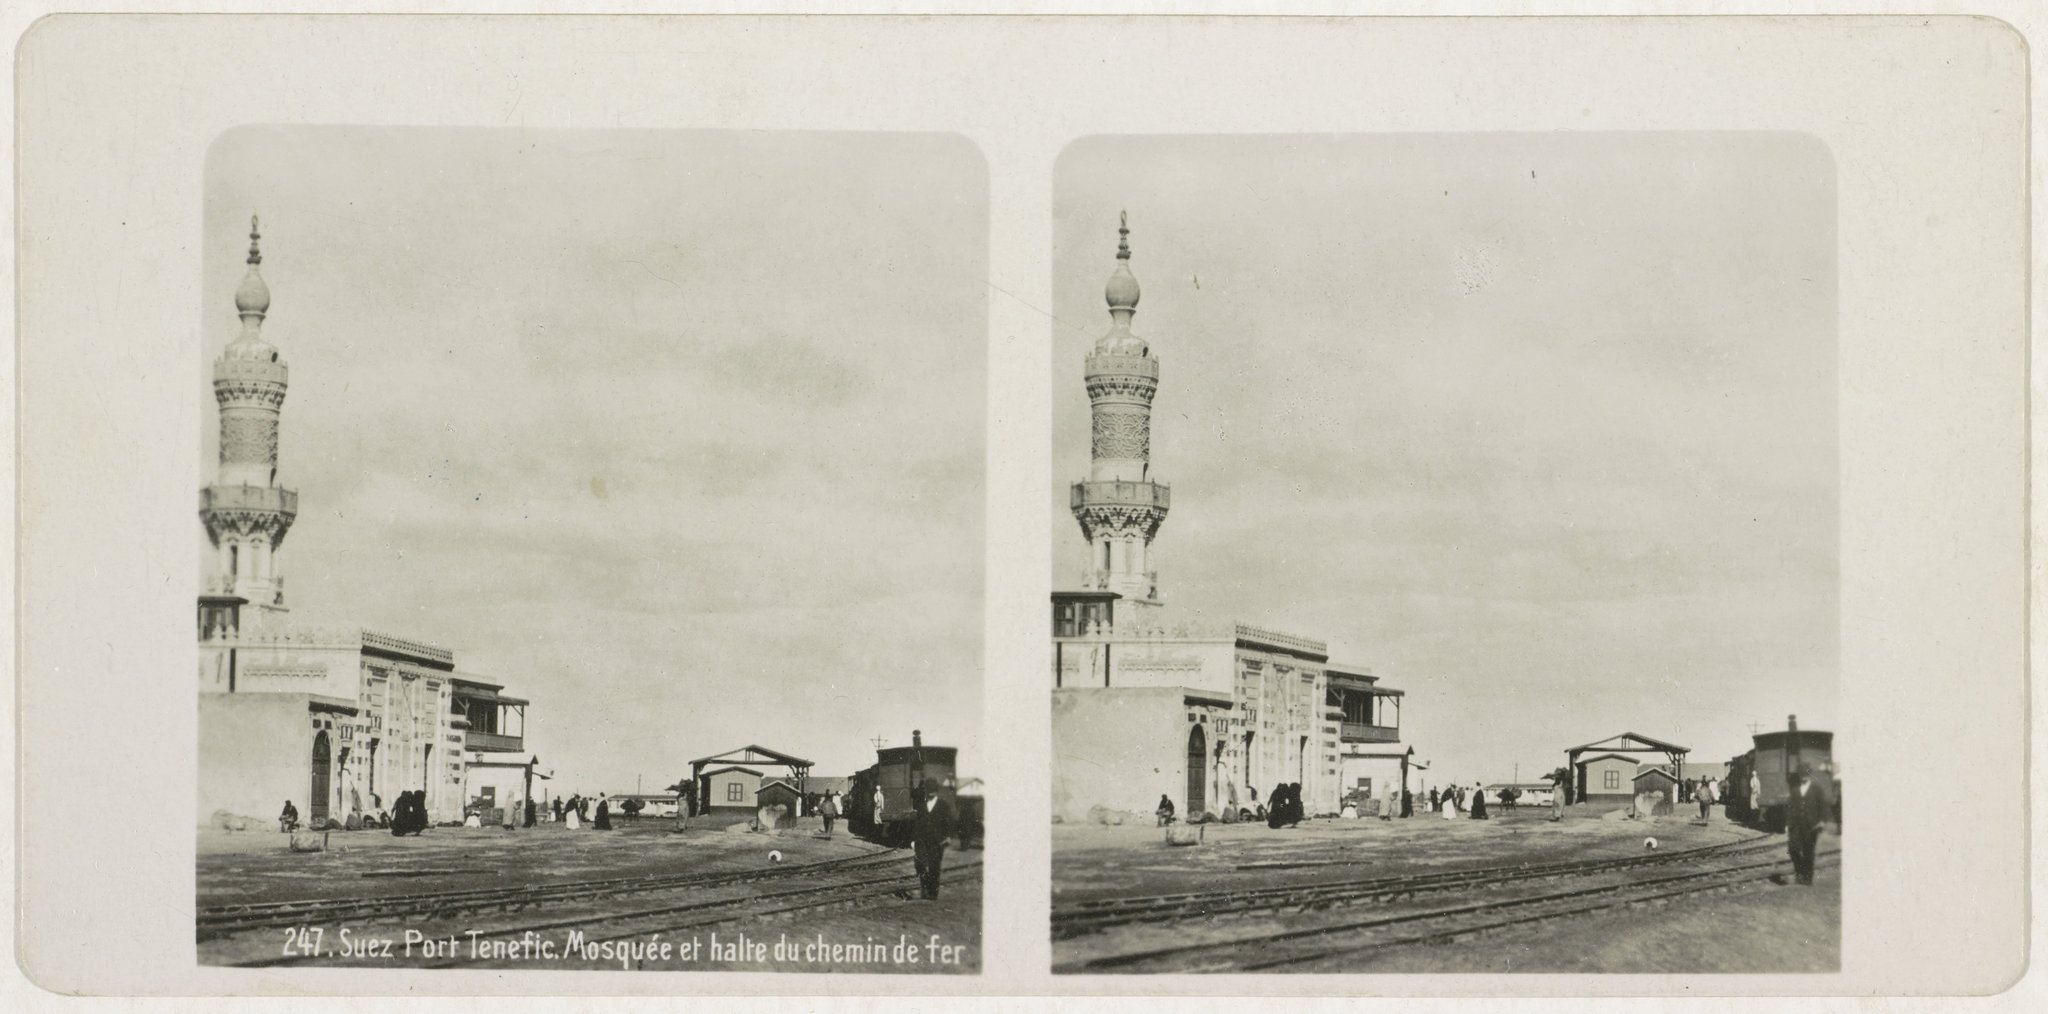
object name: stereograph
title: Spoorweg nabij een moskee in de haven van Suez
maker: richard sochor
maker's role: painter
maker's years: 1867-1925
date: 1903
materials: paper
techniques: gelatin silver print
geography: suez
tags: temple, shrine ~ islam, mohammedanism, railway, tramway; rack railway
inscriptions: address: ‘Parklaan 49/ HAARLEM/ (Holland)’, inscription: ‘Deze stereo-foto's worden in den handel gebracht en en gros en/ en détail verkocht door de ......... (...)’, number: ‘247.’, monogram, inscription: ‘Déposée.’